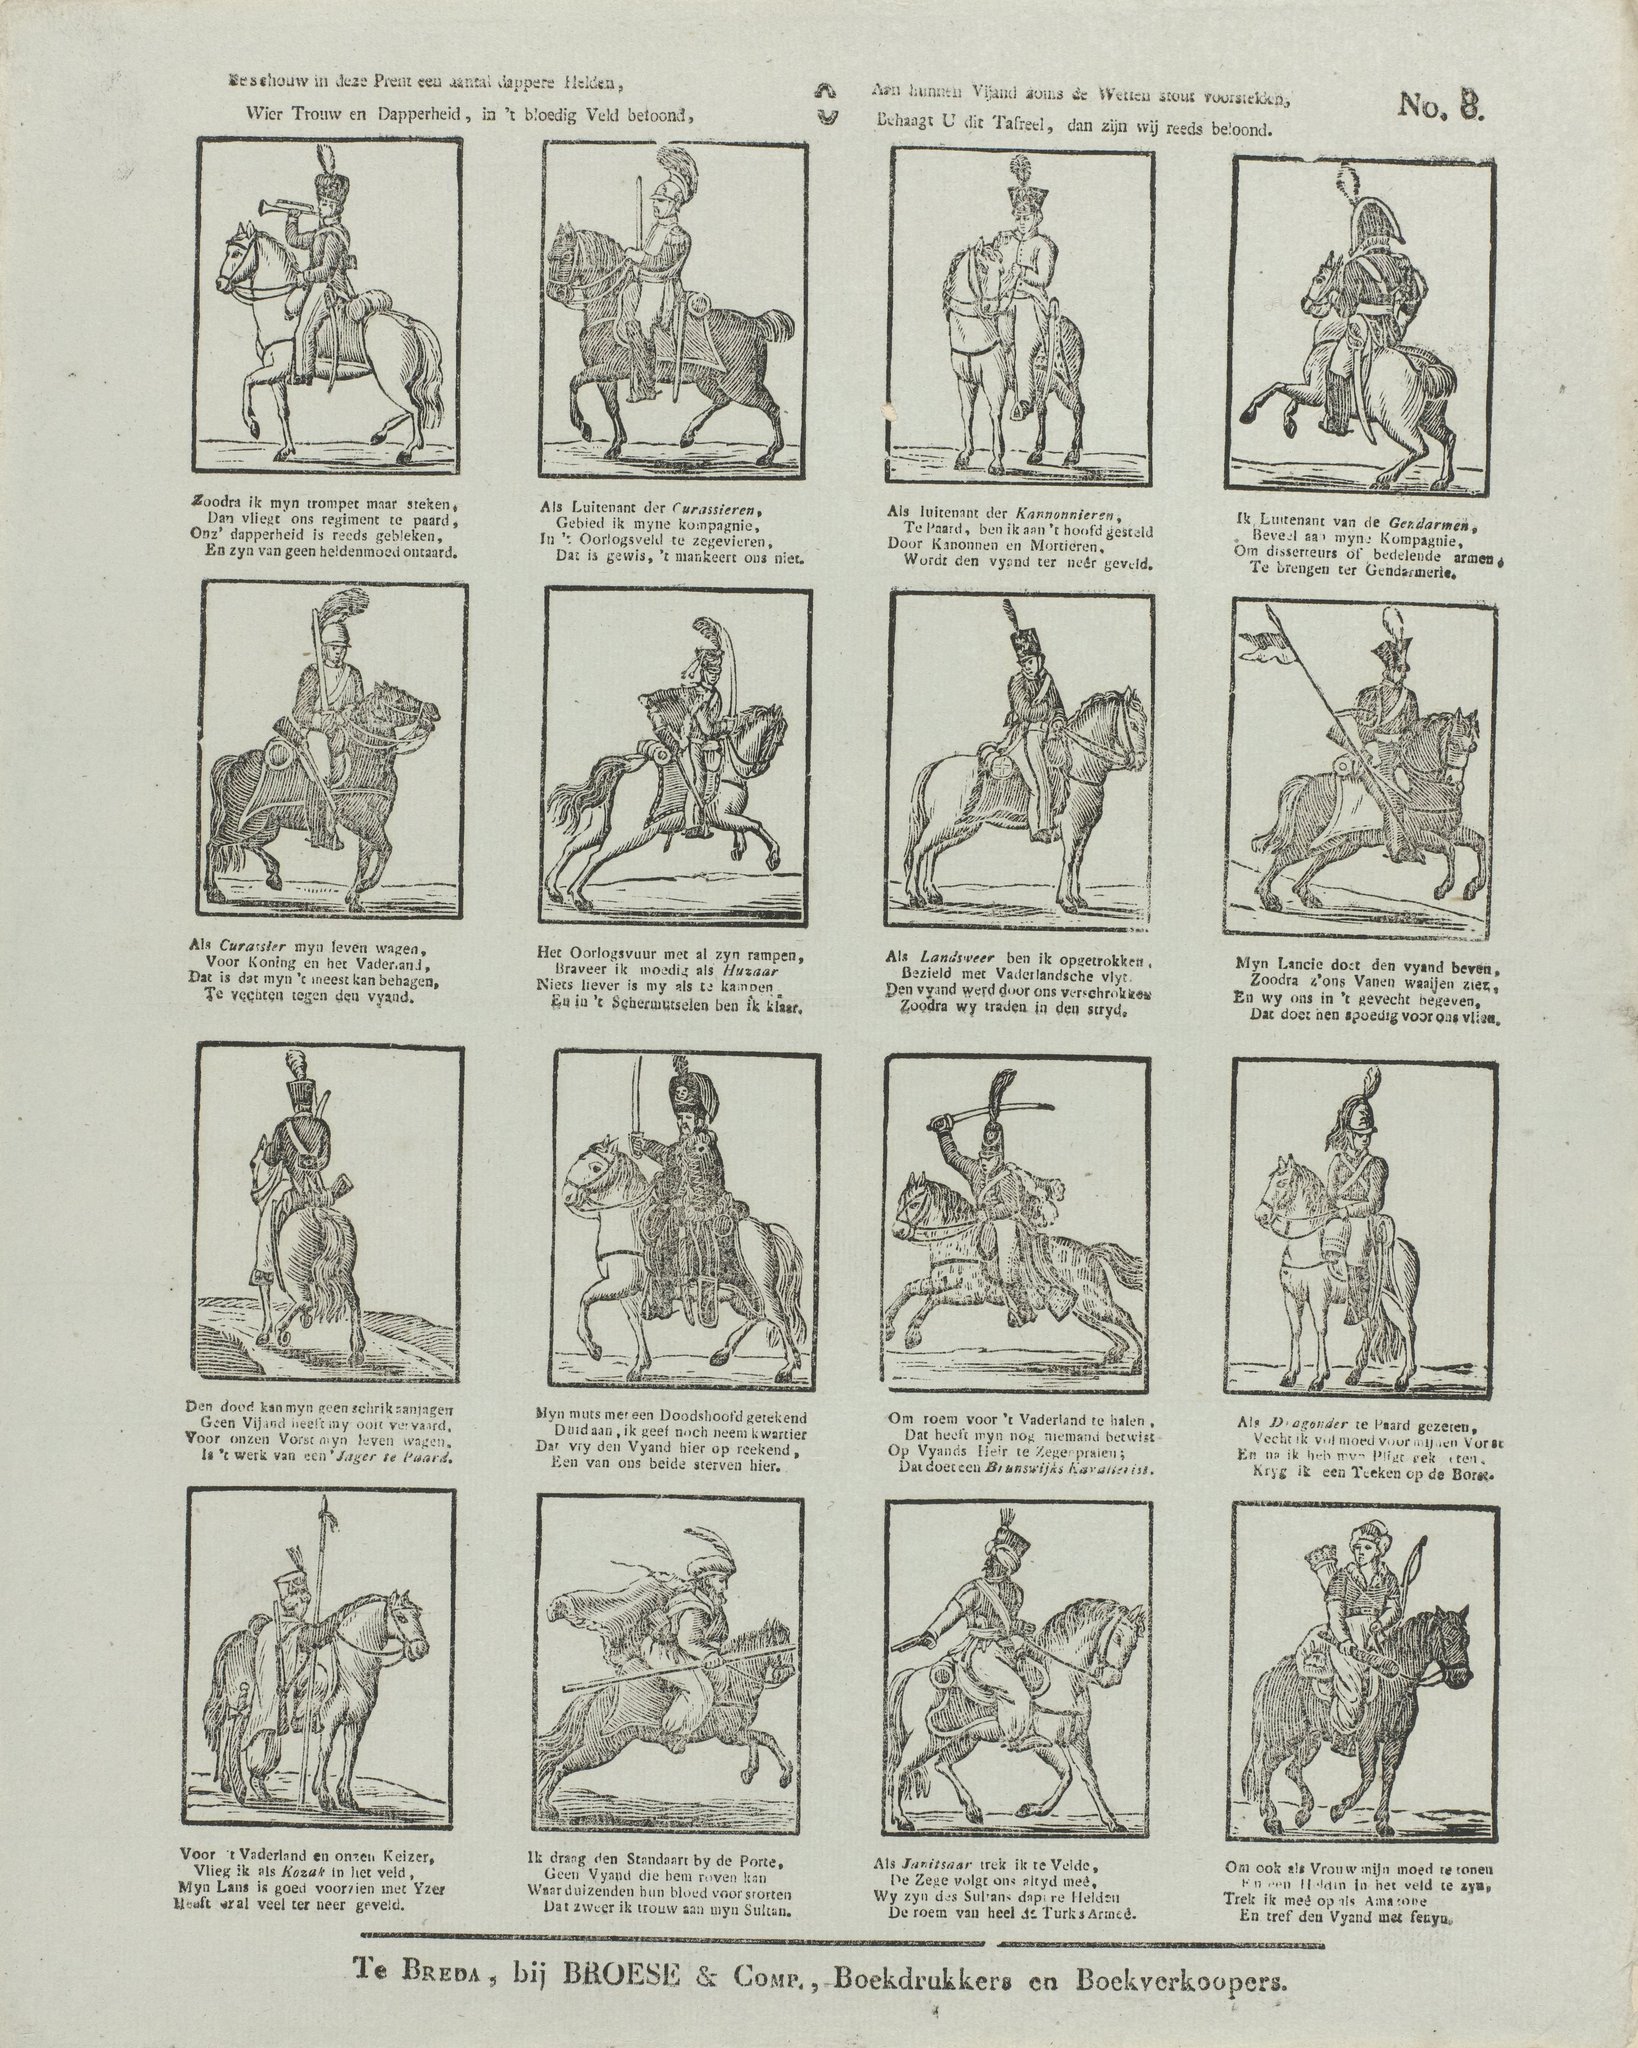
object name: print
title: Beschouw in deze prent een aantal dappere helden, / Wier trouw en dapperheid, in 't bloedig veld betoond, / Aan hunnen vijand soms de wetten stout voorstelden, / Behaagt u dit tafreel, dan zijn wij reeds beloond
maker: Anonymous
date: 1828-1853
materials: paper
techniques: letterpress printing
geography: breda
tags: warfare; military affairs (+ cavalry, horsemen), the soldier; the soldier's life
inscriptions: collector's mark: Lugt 2760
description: Blad met 16 voorstellingen van verschillende rangen soldaten te paard. Onder elke voorstelling een vierregelig vers. Genummerd rechtsboven: No. 8.